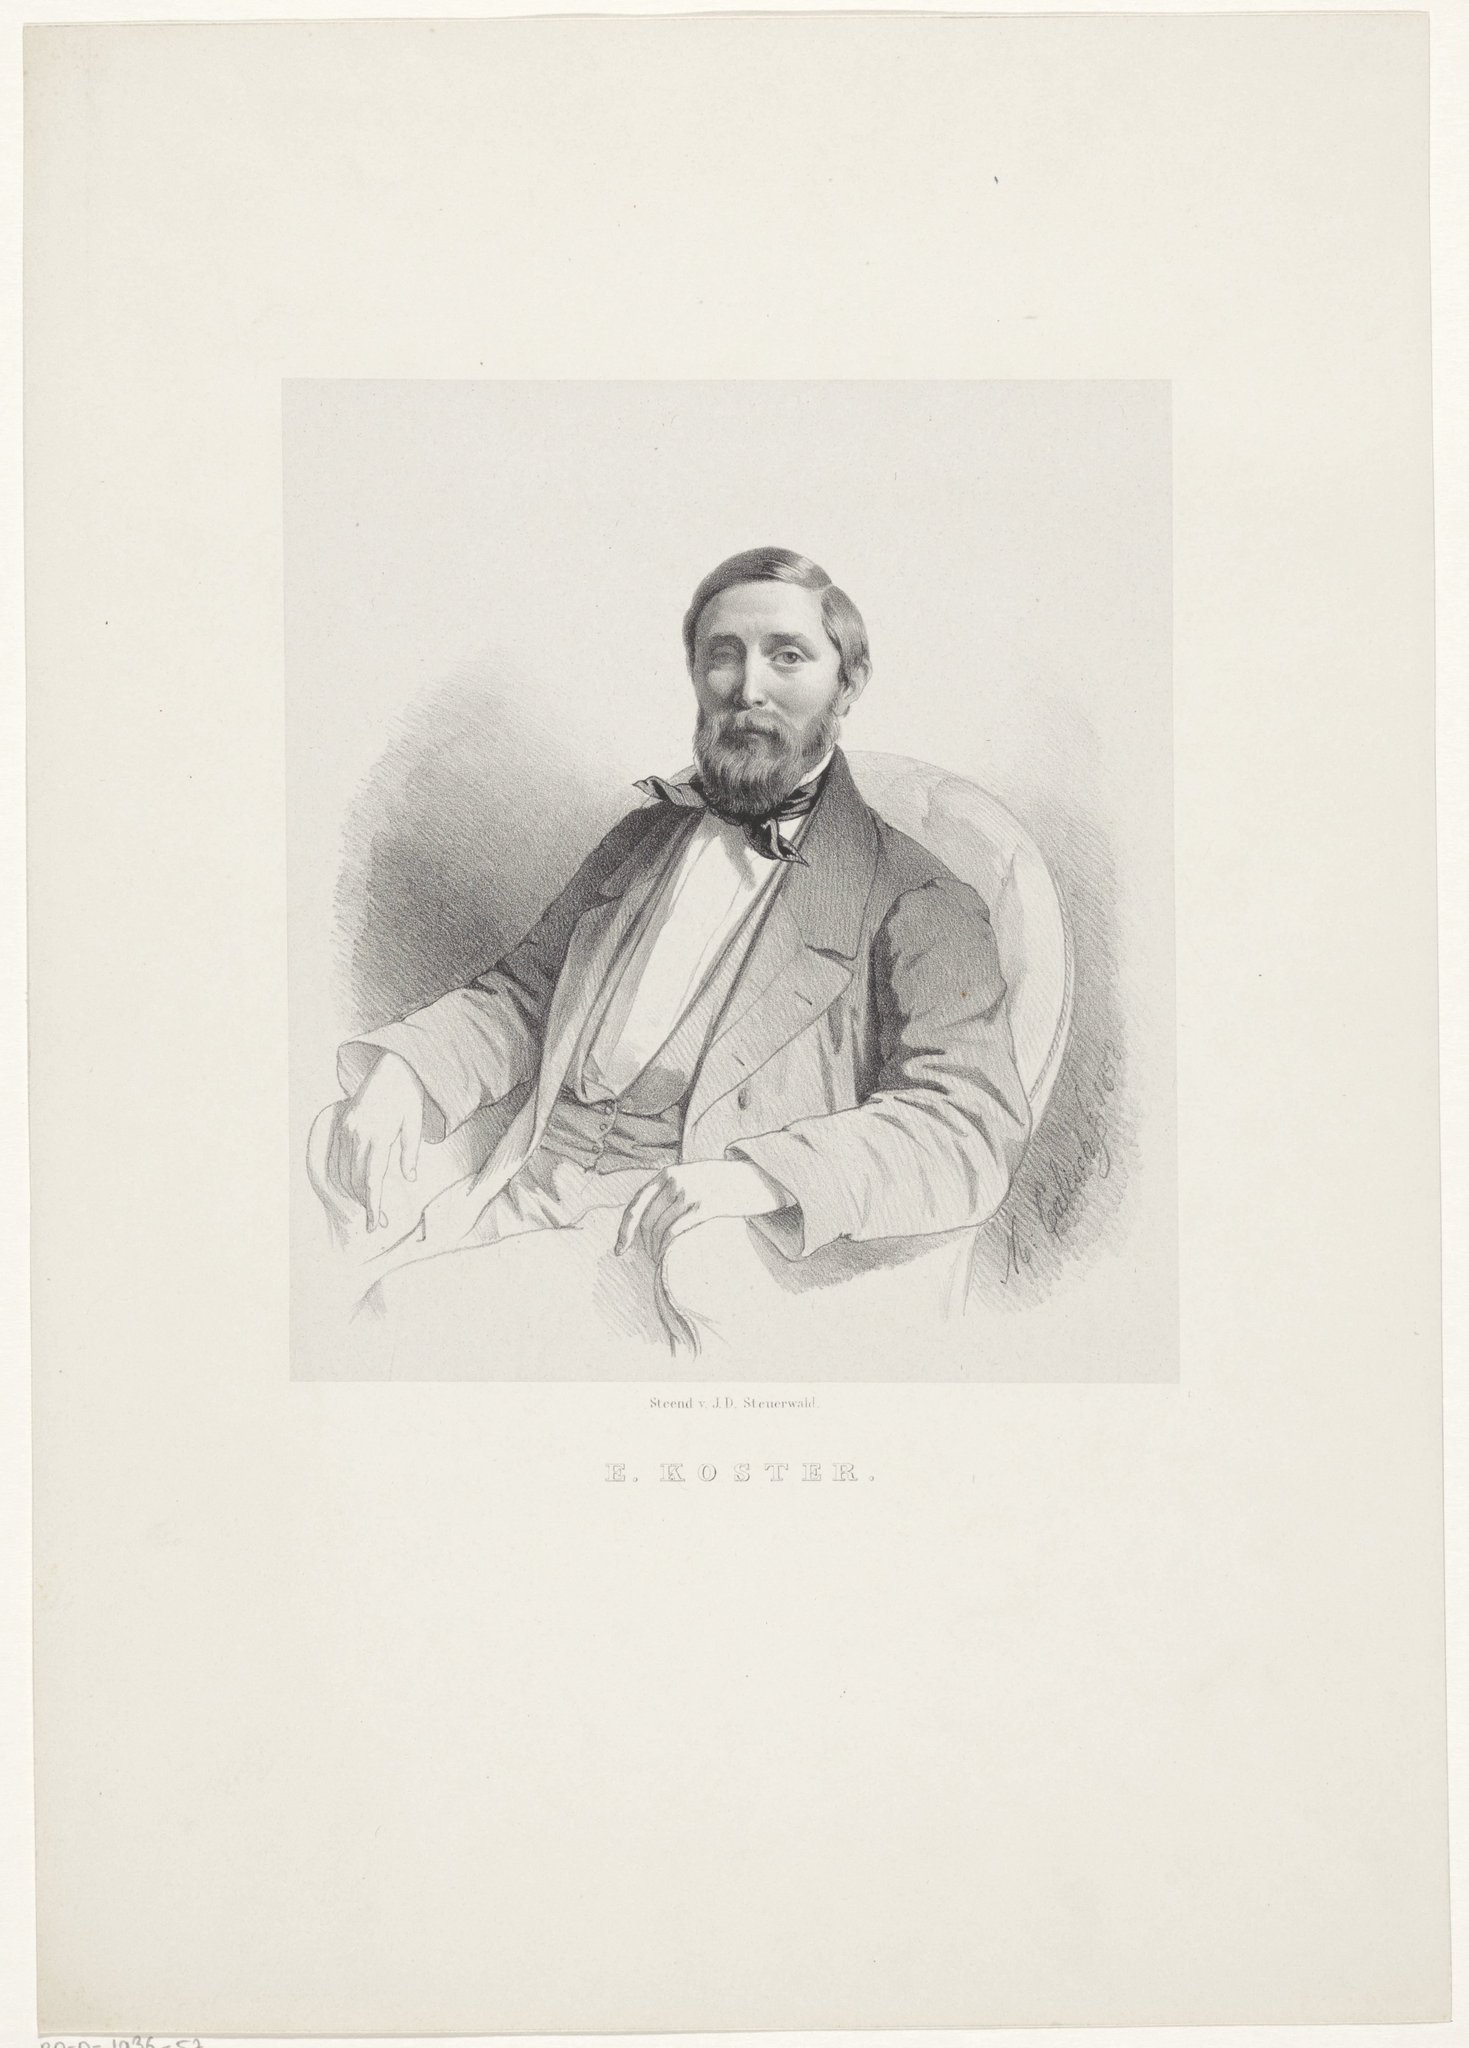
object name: print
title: Portret van Everhardus Koster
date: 1858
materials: paper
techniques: lithograph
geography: amsterdam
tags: painter, everhardus koster, adult man (+ sitting), armchair, seat, historical persons (+ three-quarter length portrait)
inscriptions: collector's mark: Lugt 2760, collector's mark: Lugt 2228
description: De geportretteerde zit in een fauteuil en rust met zijn armen op de armleuningen. Onder het portret zijn naam.